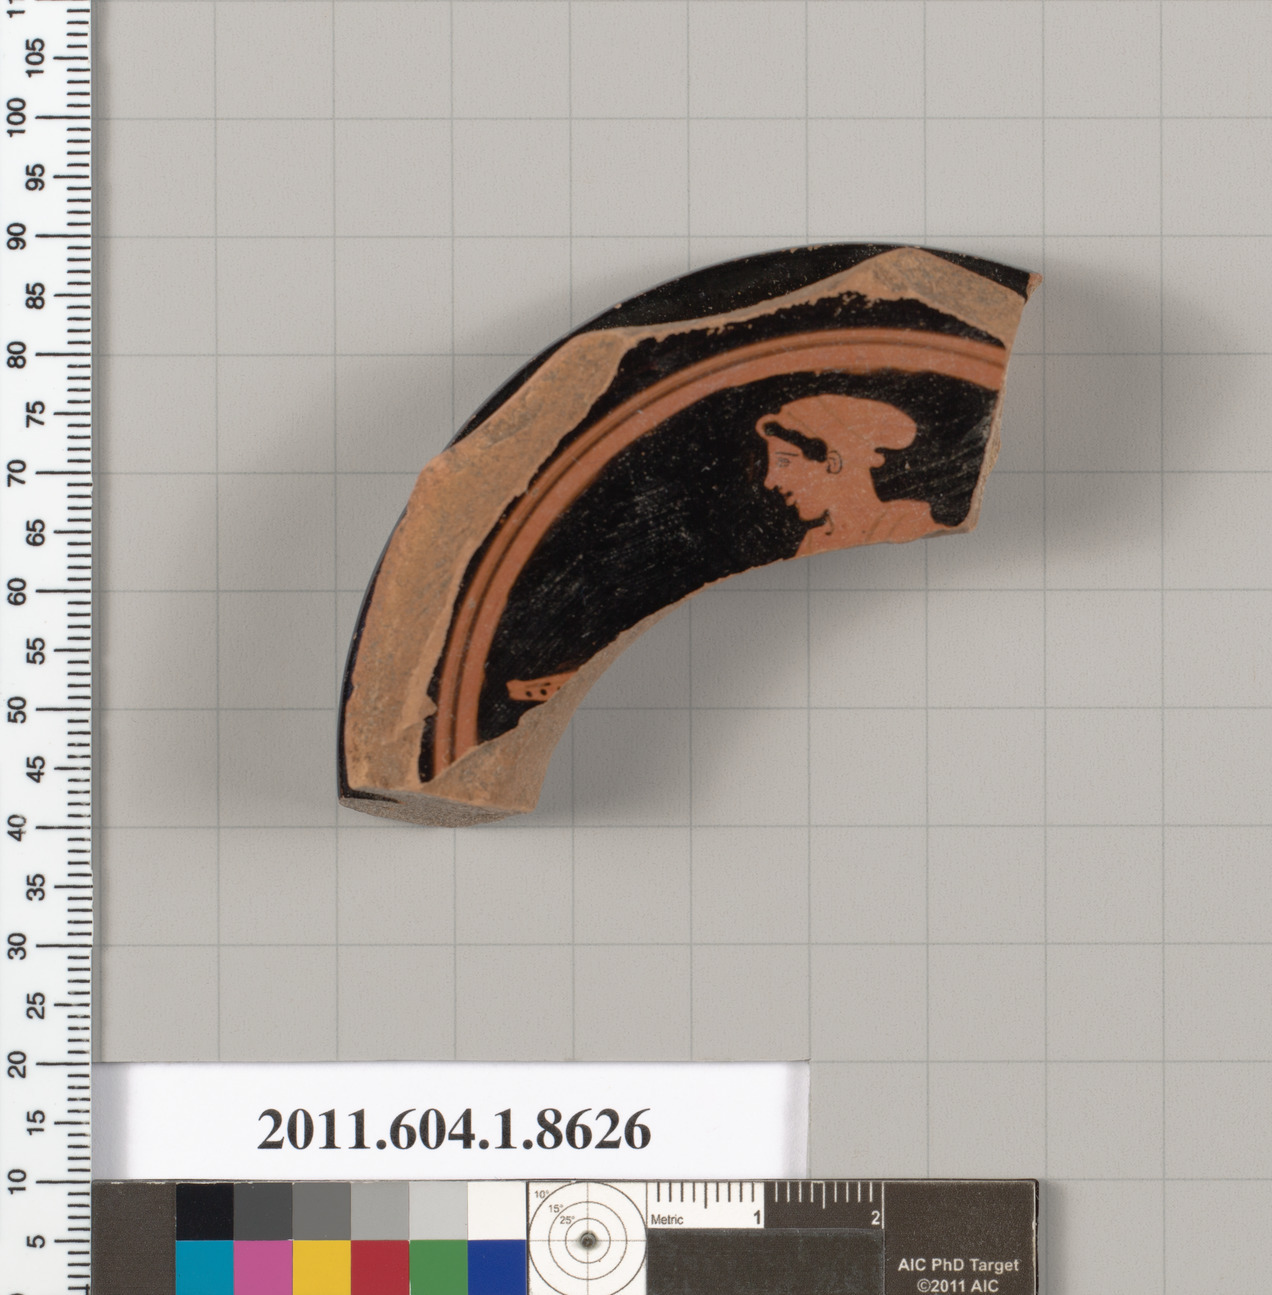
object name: kylix fragment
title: Terracotta fragment of a stemless kylix (drinking cup)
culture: greek, attic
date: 460-450 BCE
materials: terracotta